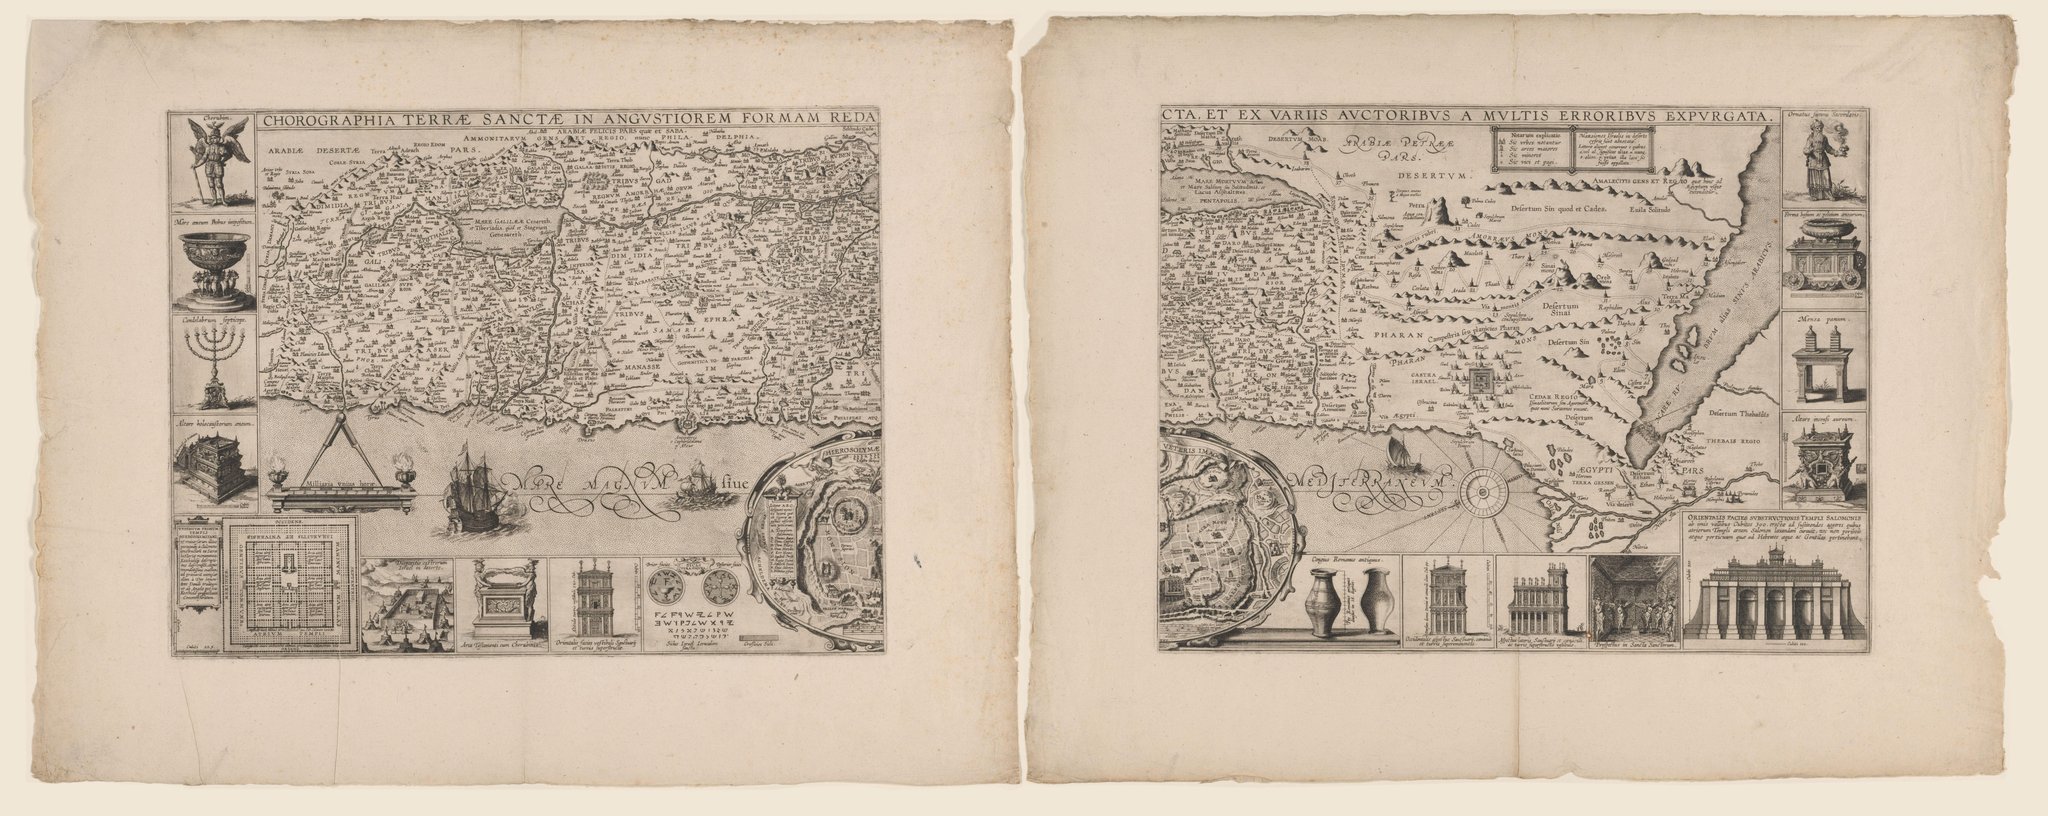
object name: area plan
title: Kaart van het Heilige Land, bestaande uit twee delen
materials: paper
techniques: engraving, etching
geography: antwerp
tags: maps of separate countries or regions, the book exodus: story of moses and aaron, maps of cities, the temple (in general) ~ jewish religion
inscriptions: collector's mark: Lugt 2228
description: Kaart van het Heilige Land. Op de kaart is de exodus uit Egypte aangegeven, alsmede verschillende Bijbelse plaatsen en steden. Onder, in het midden, een inzet met een plattegrond van Jeruzalem, waarop de belangrijkste tempels en gebouwen zijn aangegeven. Verder zijn rond de kaart verschillende Bijbelse objecten, gezichten op tempels en andere religieuze voorstellingen te zien.